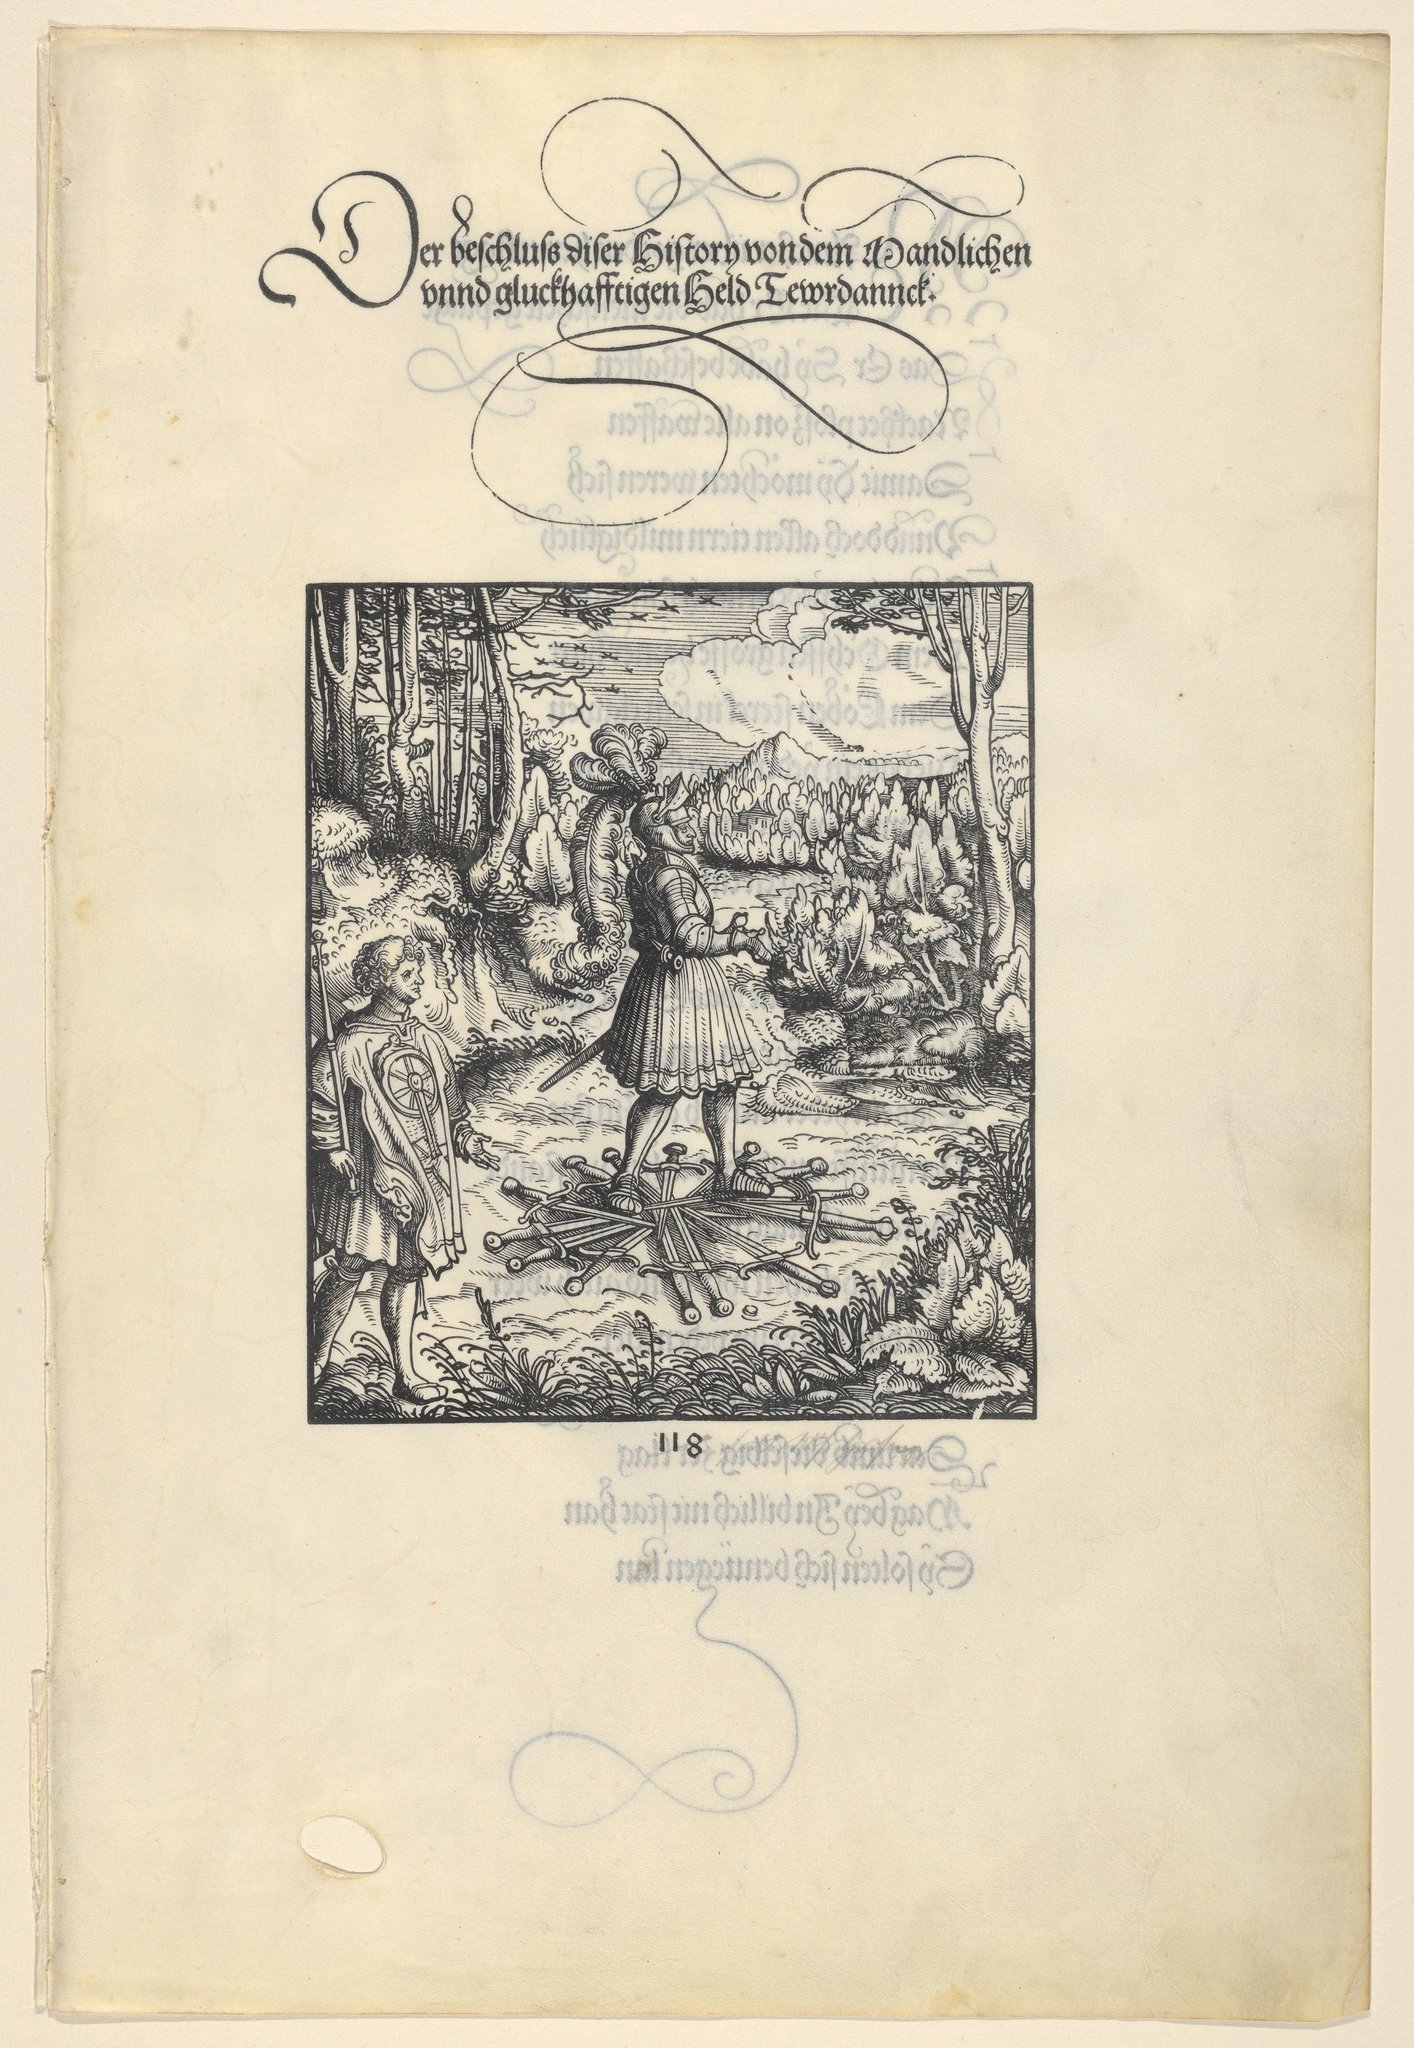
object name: print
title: Theuerdank Walking on Swords, from [Theuerdank] Die geuerlicheiten vnd einsteils der geschichten des loblichen streytparen vnd hochberümbten helds vnd Ritters herr Tewrdannckhs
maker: hans burgkmair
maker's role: artist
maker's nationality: german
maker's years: 1473-1531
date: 1517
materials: parchment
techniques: woodcut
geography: germany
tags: swords,men,walking,knights